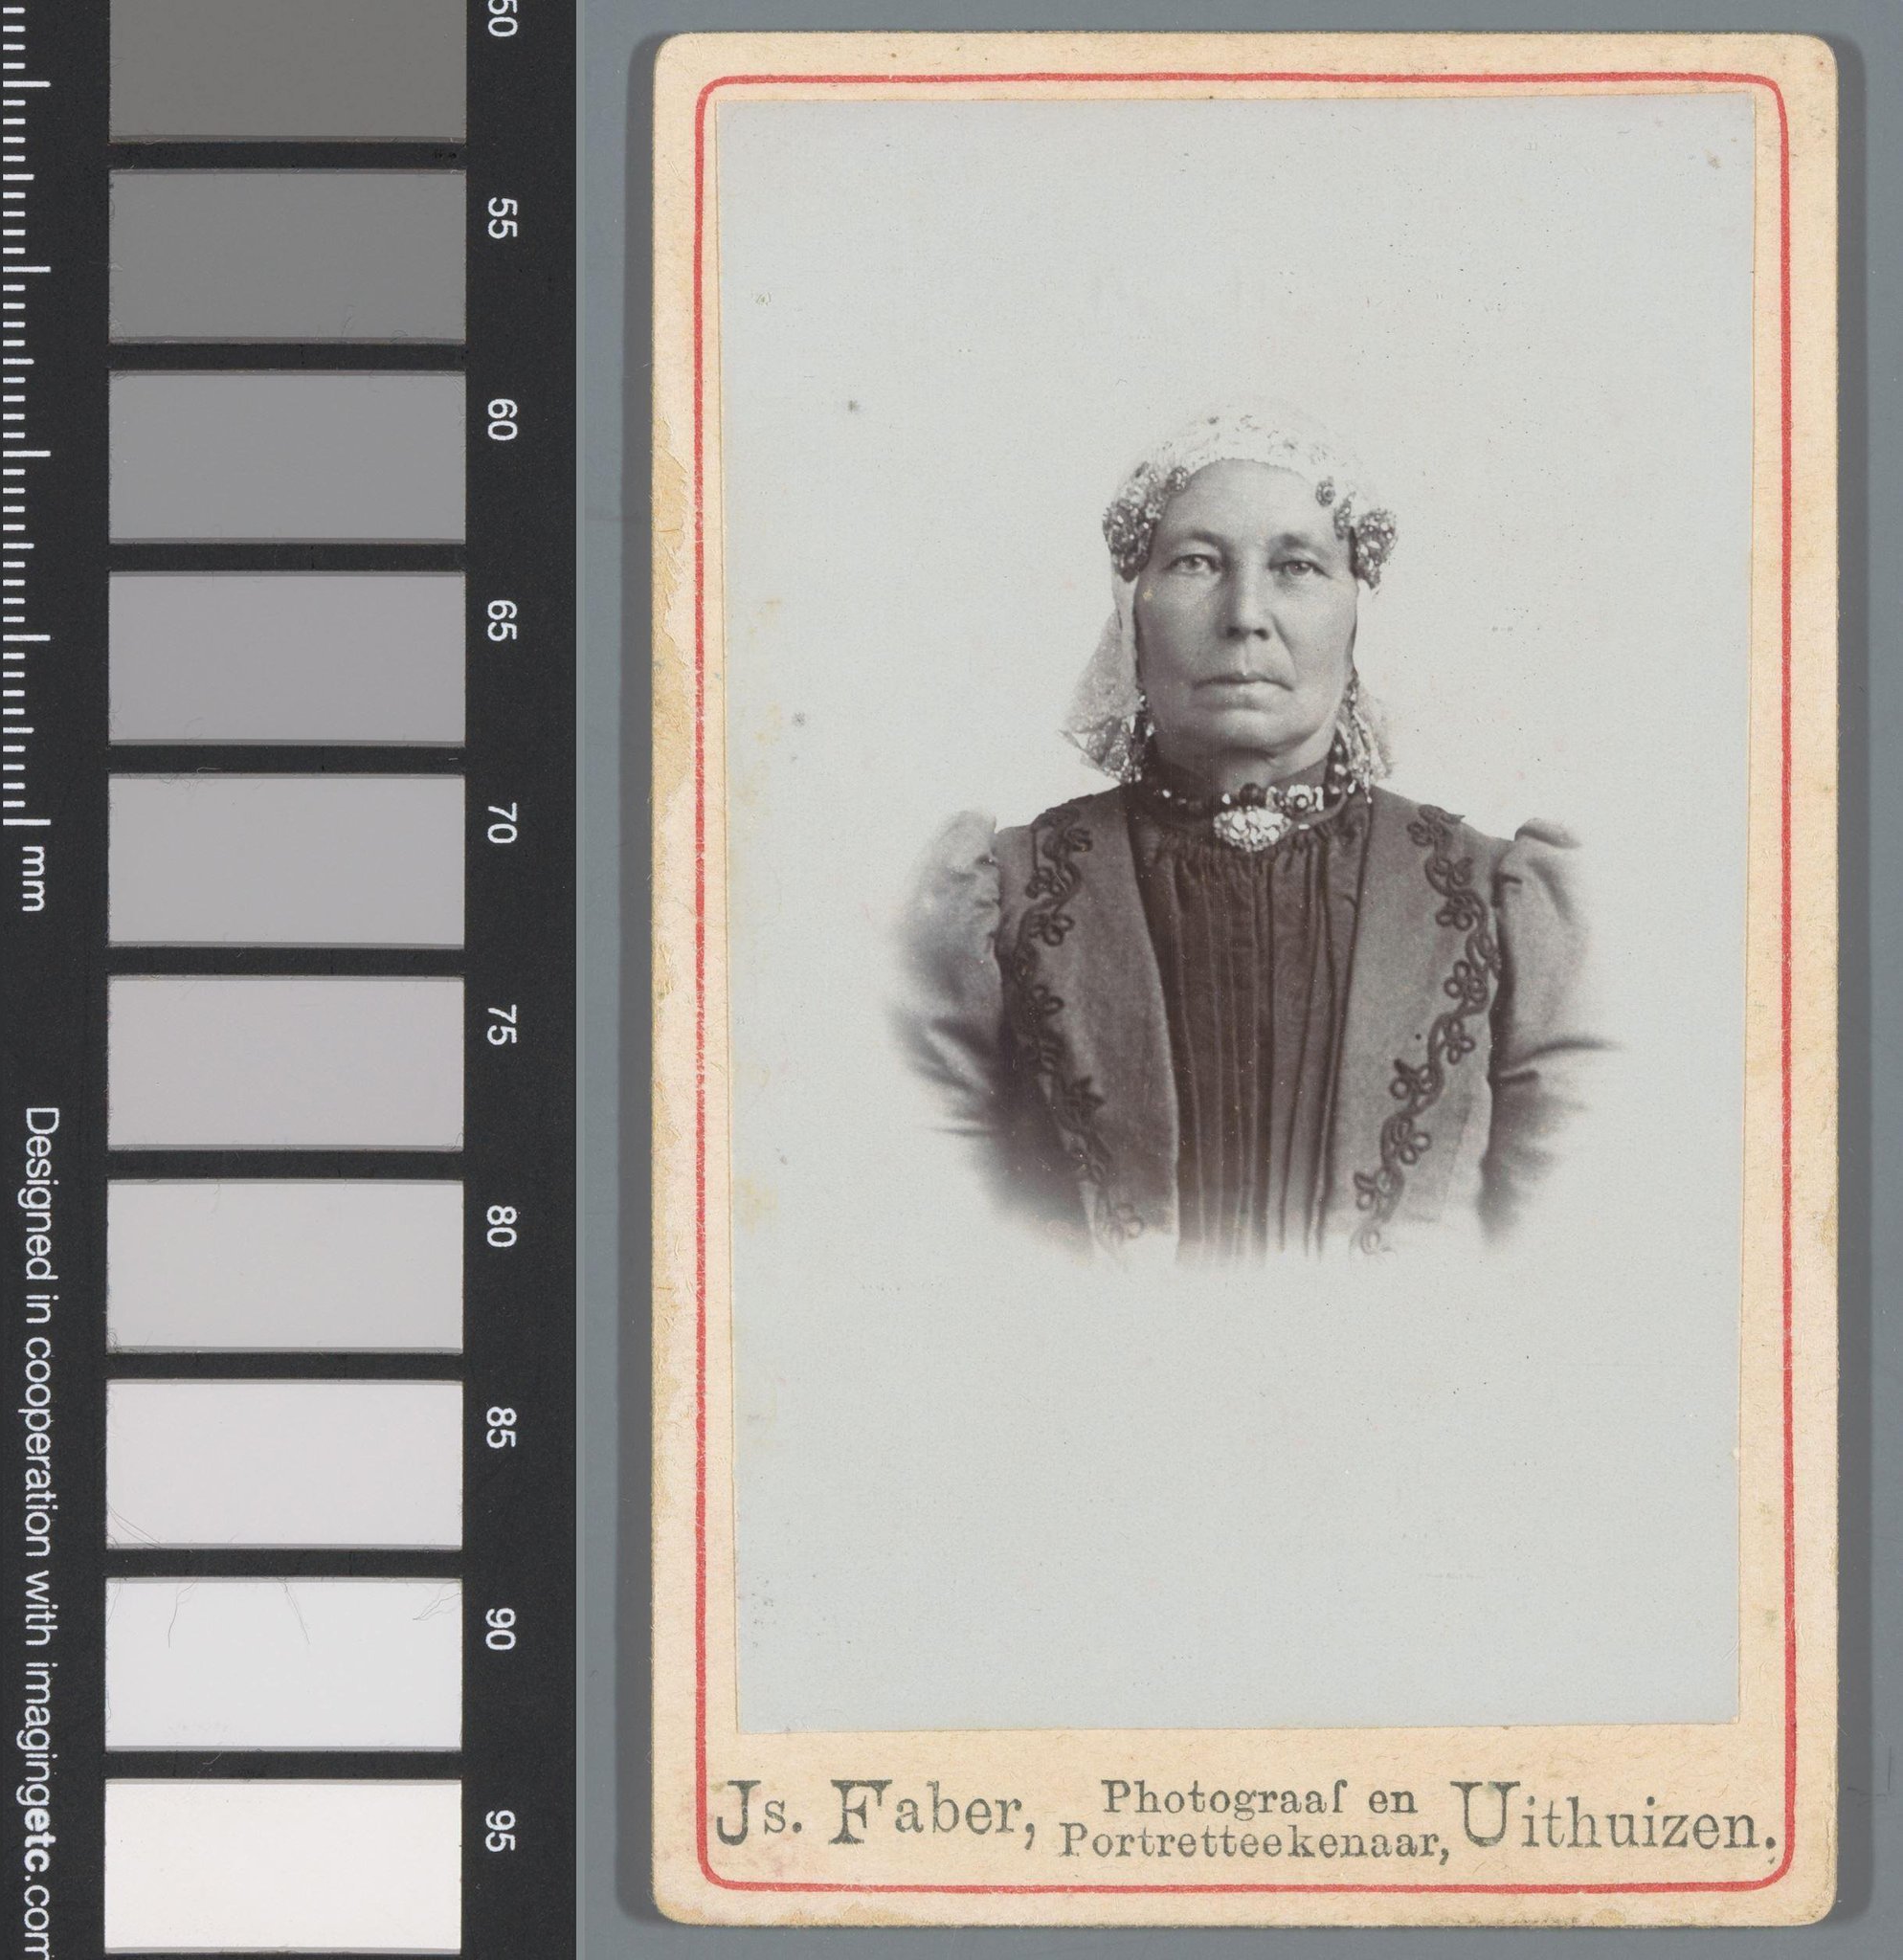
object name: carte de visite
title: Portret van een onbekende vrouw in klederdracht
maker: jannes faber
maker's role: fotograaf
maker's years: 1874-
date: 1897-1909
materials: cardboard, photographic support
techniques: collodion silver print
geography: uithuizen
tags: historical persons - bb - woman, folk costume, regional costume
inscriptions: inscription: ‘Js. Faber, Photograaf en/ Portretteekenaar, Uithuizen.’